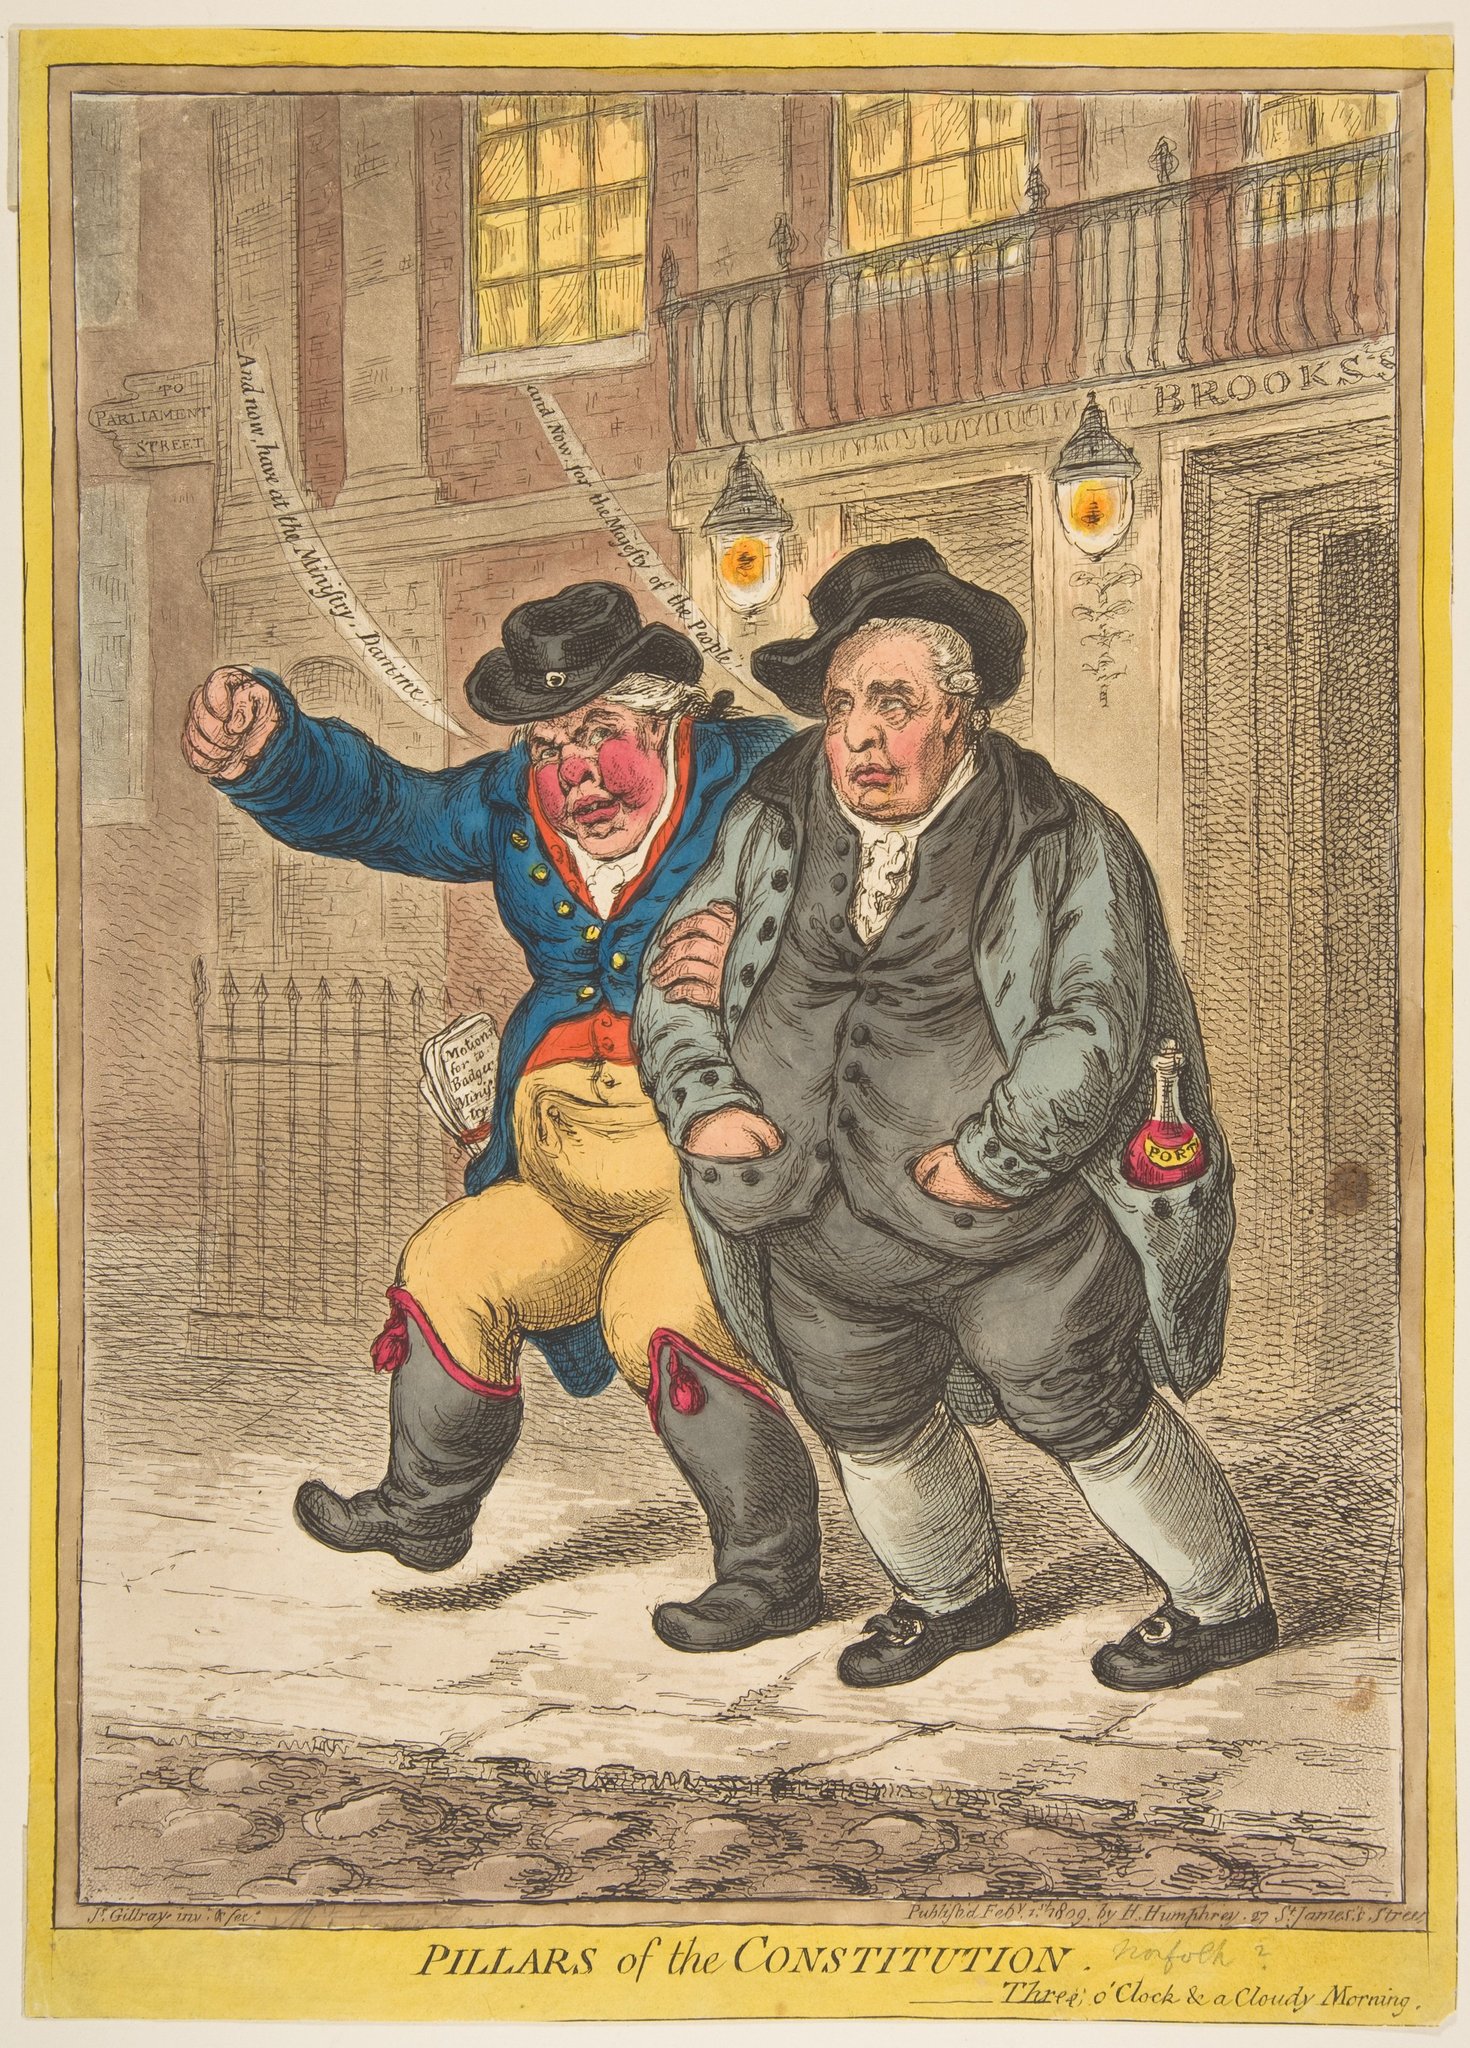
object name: print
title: Pillars of the Constitution. Three O'Clock & a Cloudy Morning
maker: james gillray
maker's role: artist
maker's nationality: british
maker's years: 1756-1815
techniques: etching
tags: satire,men,politics